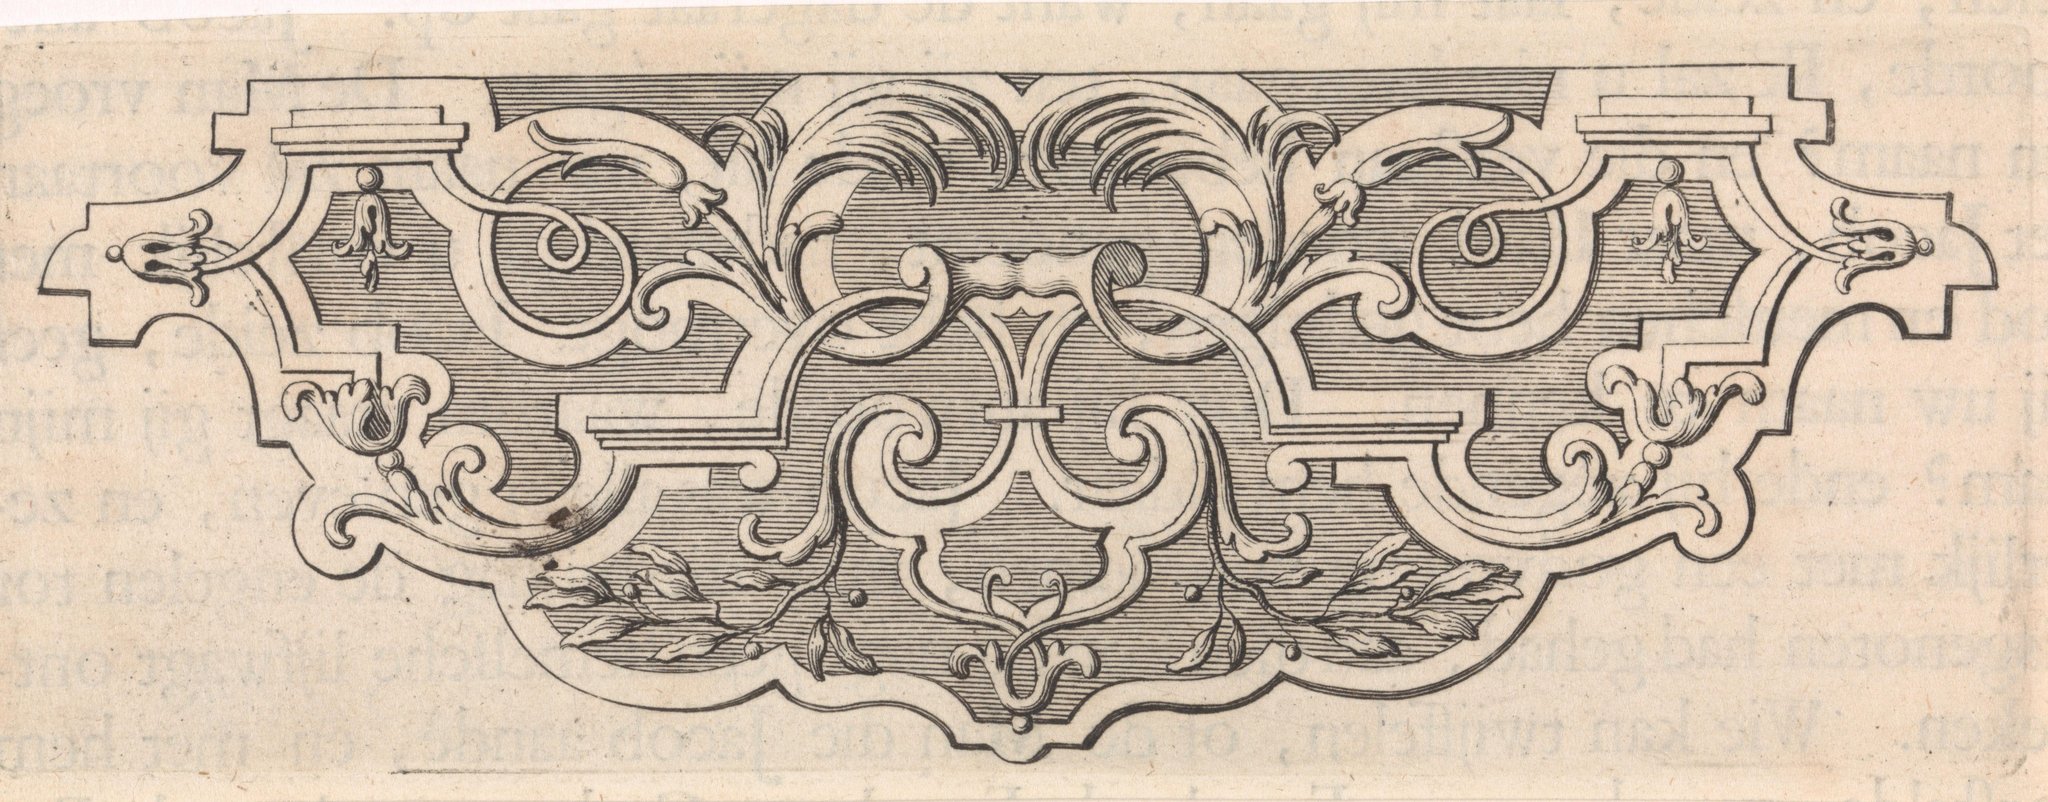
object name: print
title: Vignet met rolwerk en bladranken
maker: bernard picart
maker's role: draughtsman, print maker, publisher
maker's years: 1673-1733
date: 1683-1733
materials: paper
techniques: etching, letterpress printing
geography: amsterdam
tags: scrollwork, strapwork ~ ornament, foliage, tendrils, branches ~ ornament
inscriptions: collector's mark: Lugt 2228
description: Prent oorspronkelijk bedoeld voor: Figures de la Bible. Amsterdam, Bernard Picart, 1720. Prent ook gebruikt in: Taferelen der voornaamste geschiedenissen van het Oude en Nieuwe Testament (...) door de vermaarde kunstenaars Hoet, Houbraken, en Picart getekent (...) en met beschrijvingen uitgebreid. Den Haag: Pieter de Hondt, 1728. Prent kan mogelijk ook zijn gebruikt in andere bijbels.